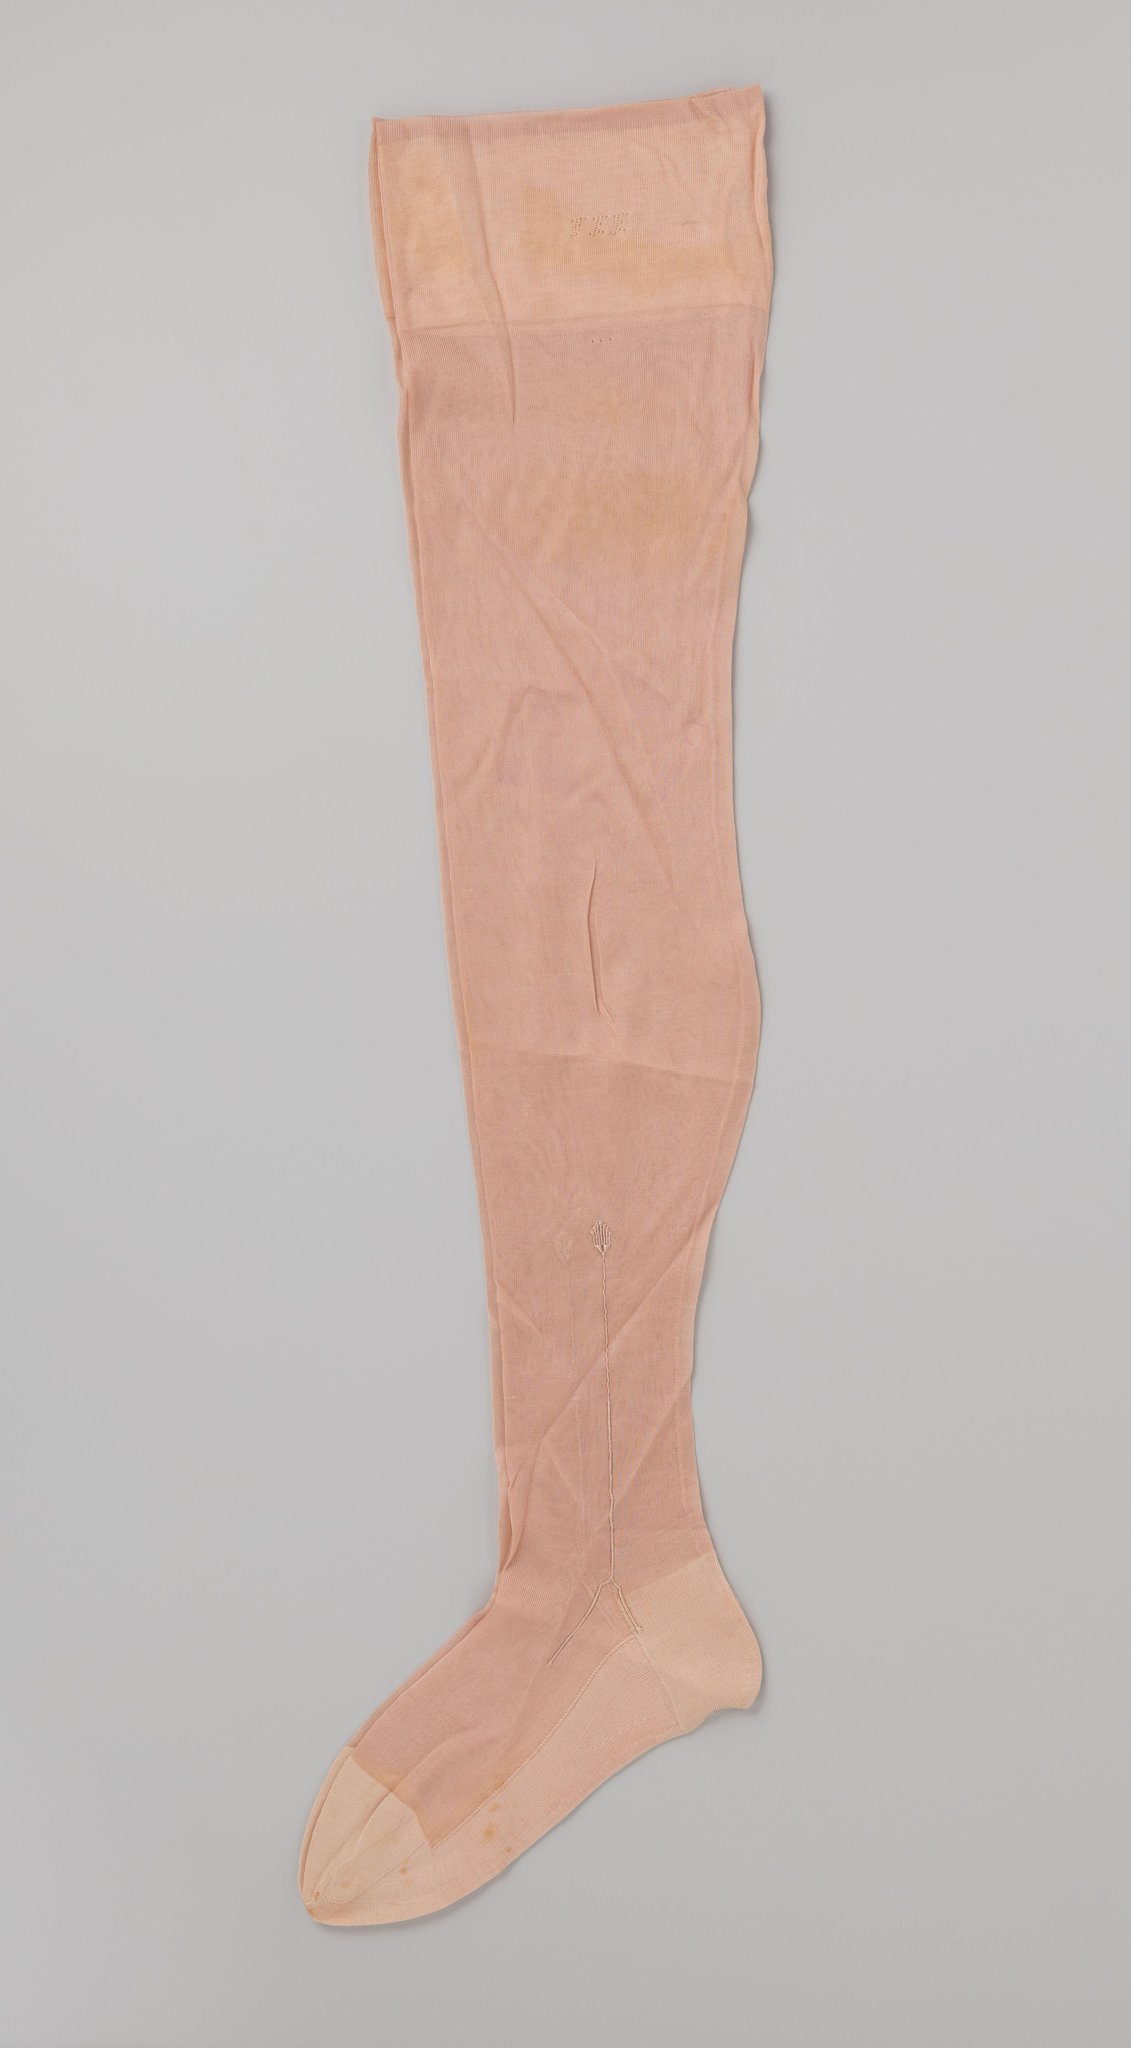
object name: stocking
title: Lange dameskous van vleeskleurige zijden tricot met ingeweven kroon en '200'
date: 1900-1940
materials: silk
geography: oberlungwitz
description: Lange dameskous van vleeskleurige zijden tricot met ingeweven kroon en '200' in doorzichtige kunststof verpakking met opdruk 'LBO/ 200/ Krone/ Elbeo'. Model: naad middenachter. Verstevigde voorvoet en hiel. Dubbele boord aan bovenkant Versiering: vanaf de klinken tot halverwege de kuit een opengewerkte rand eindigt in een ruitvorm (gestileerde bloem op steel?). Gemerkt met goudverf (opdruk) aan punt van voorvoet 'LBO', voor 'Louis Bahner Oberlungwitz'.